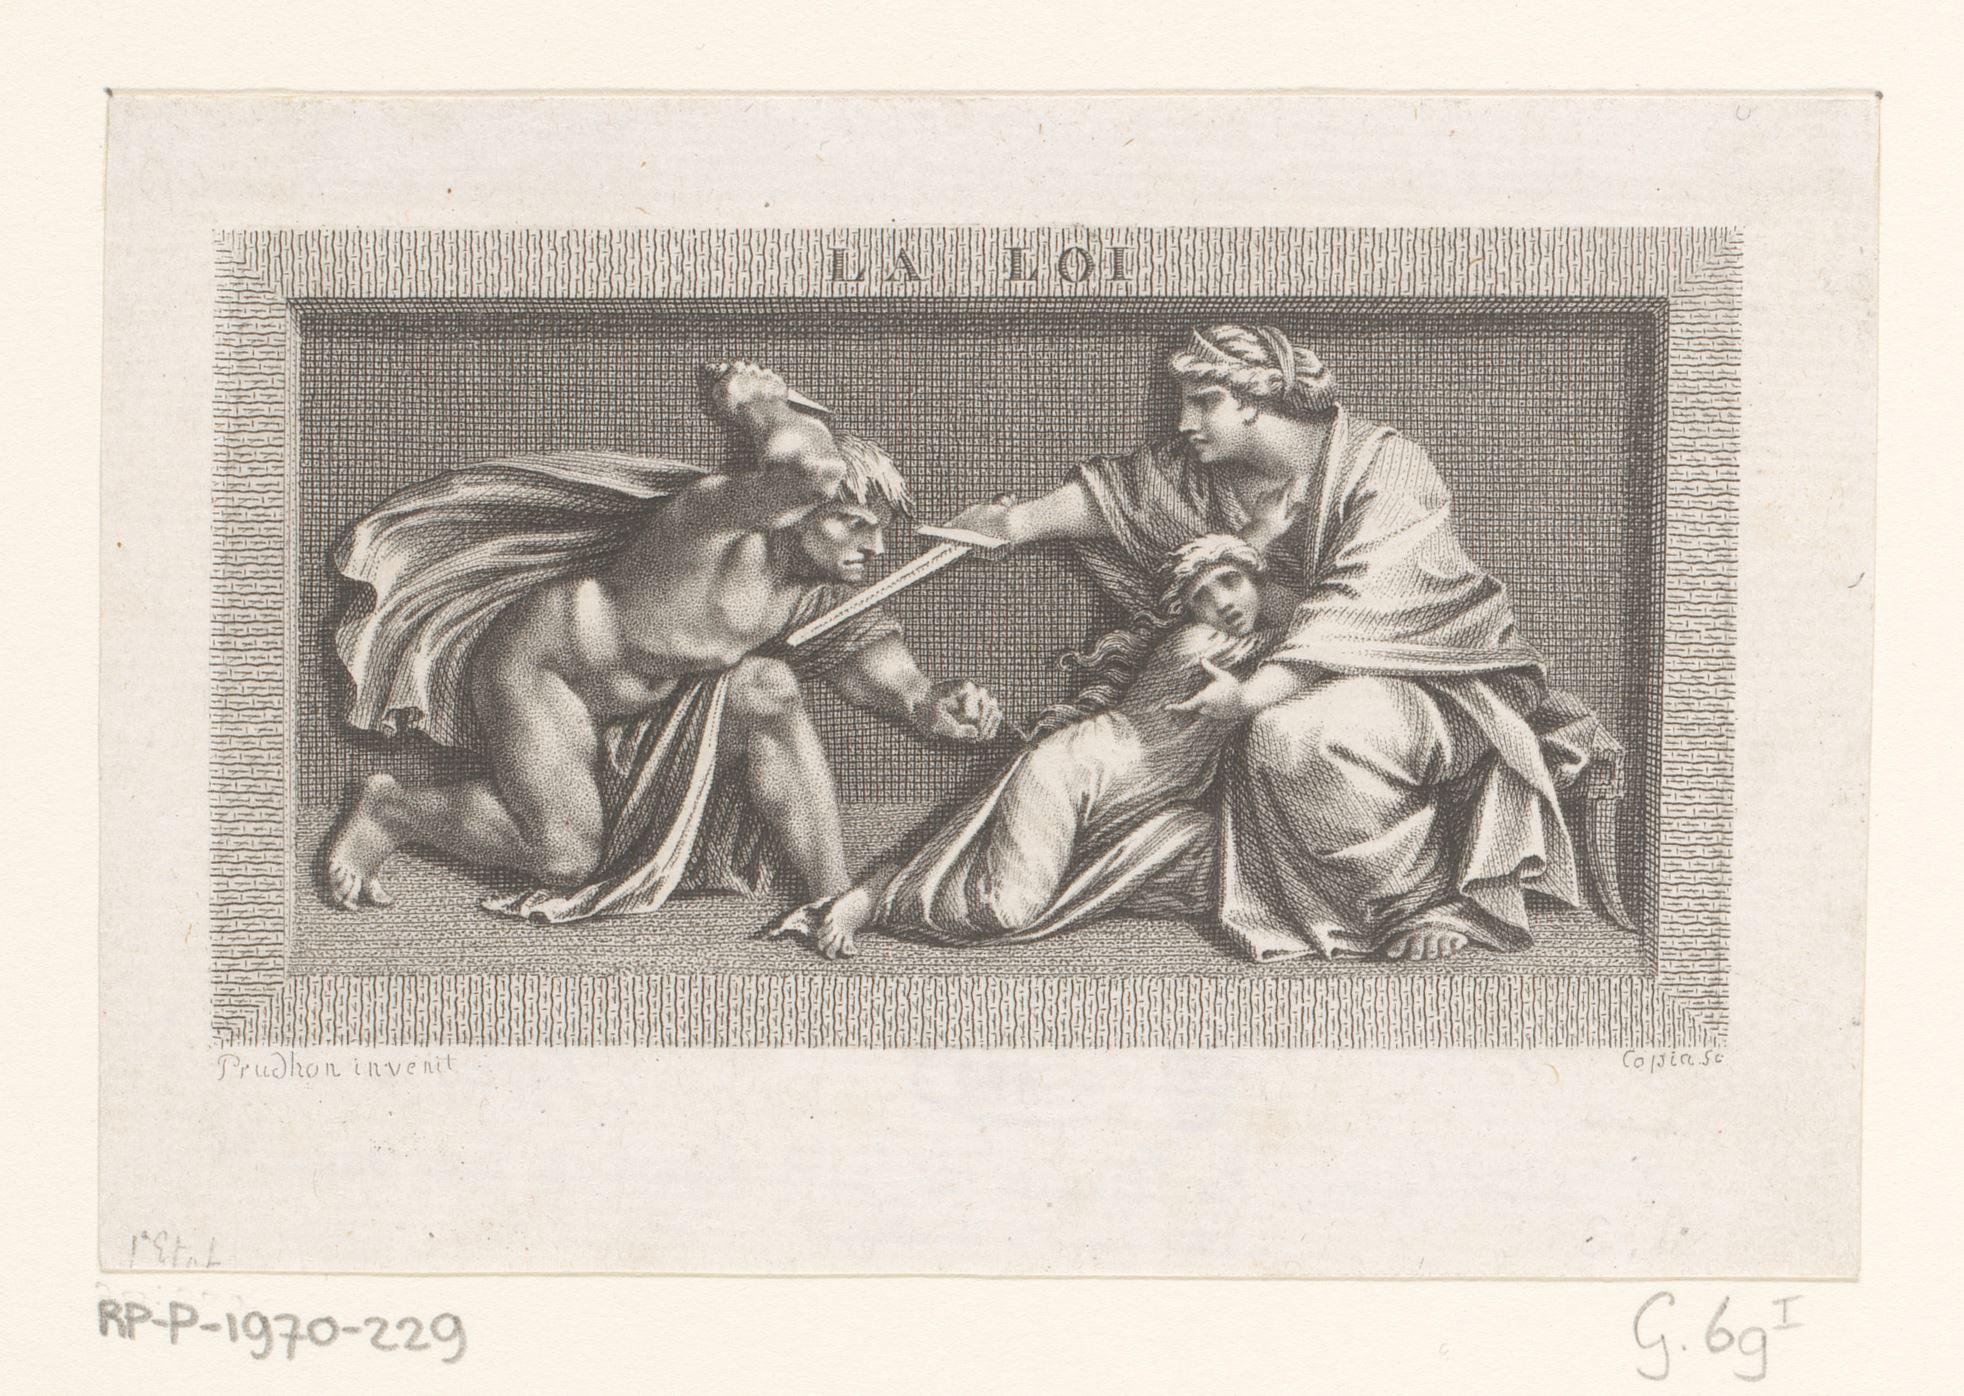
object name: print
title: La Loi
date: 1789-1799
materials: paper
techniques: engraving, etching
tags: justitia (justice) as roman personification, justice; 'forza alla giustitia sottoposta', 'giustitia', 'giustitia retta', 'giustitia rigorosa', 'impietà e violenza soggetta alla giustitia' (ripa), innocence; 'innocenza', 'innocenza o purità' (ripa)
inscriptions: collector's mark: Lugt 2760, collector's mark: Lugt 2228